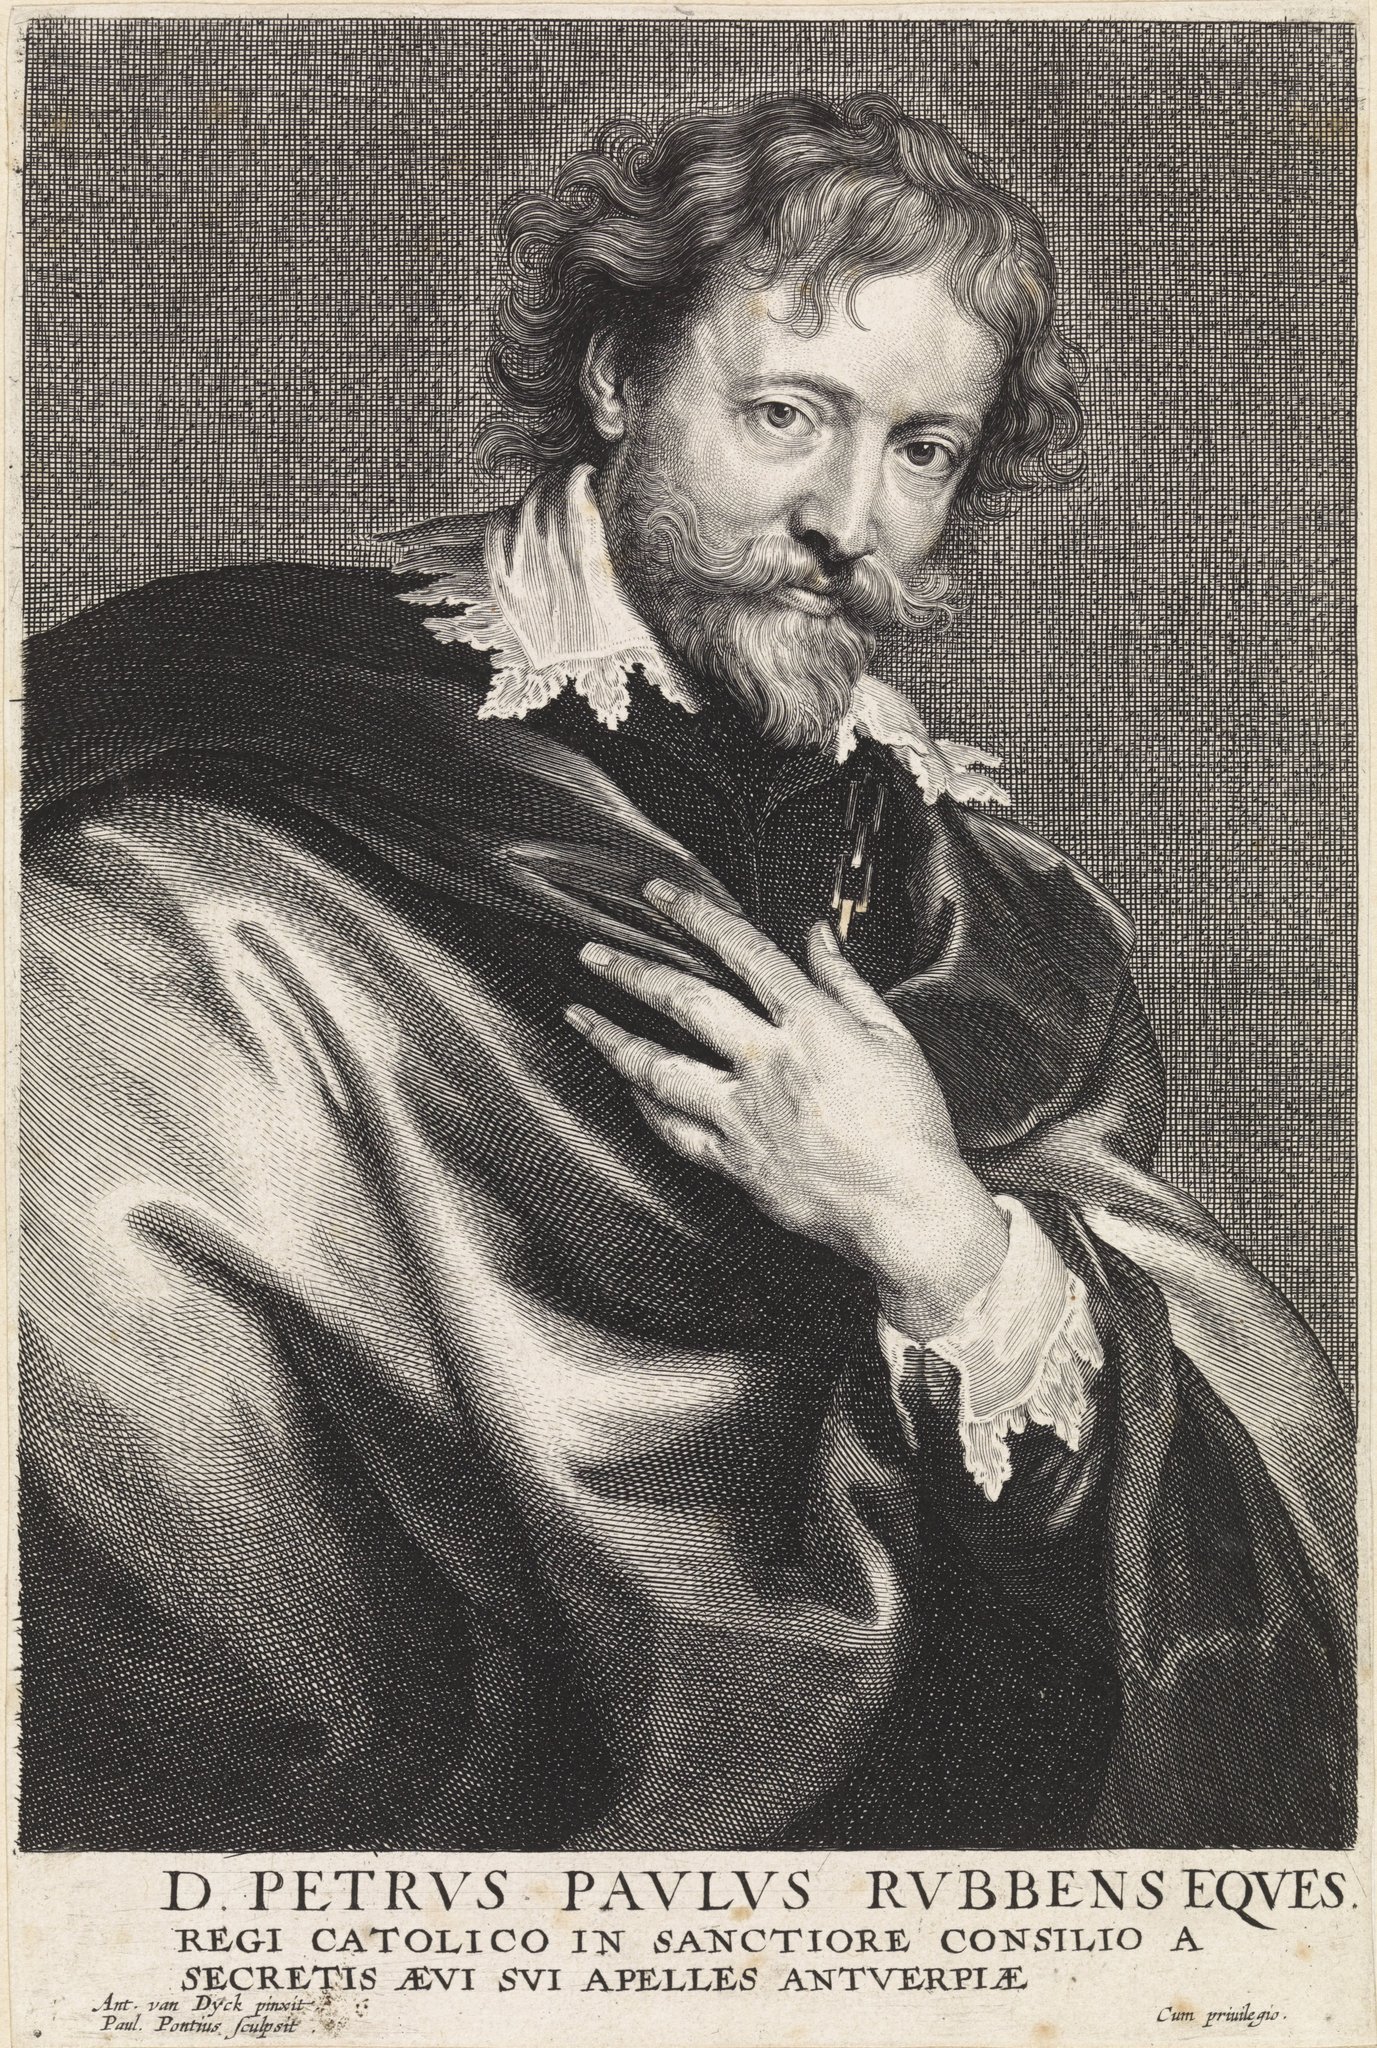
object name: print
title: Portret van de schilder Peter Paul Rubens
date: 1616-1657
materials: paper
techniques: engraving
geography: antwerp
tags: antwerp, painter, print maker, draughtsman, peter paul rubens, portrait, self-portrait of painter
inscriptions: collector's mark: Lugt 240